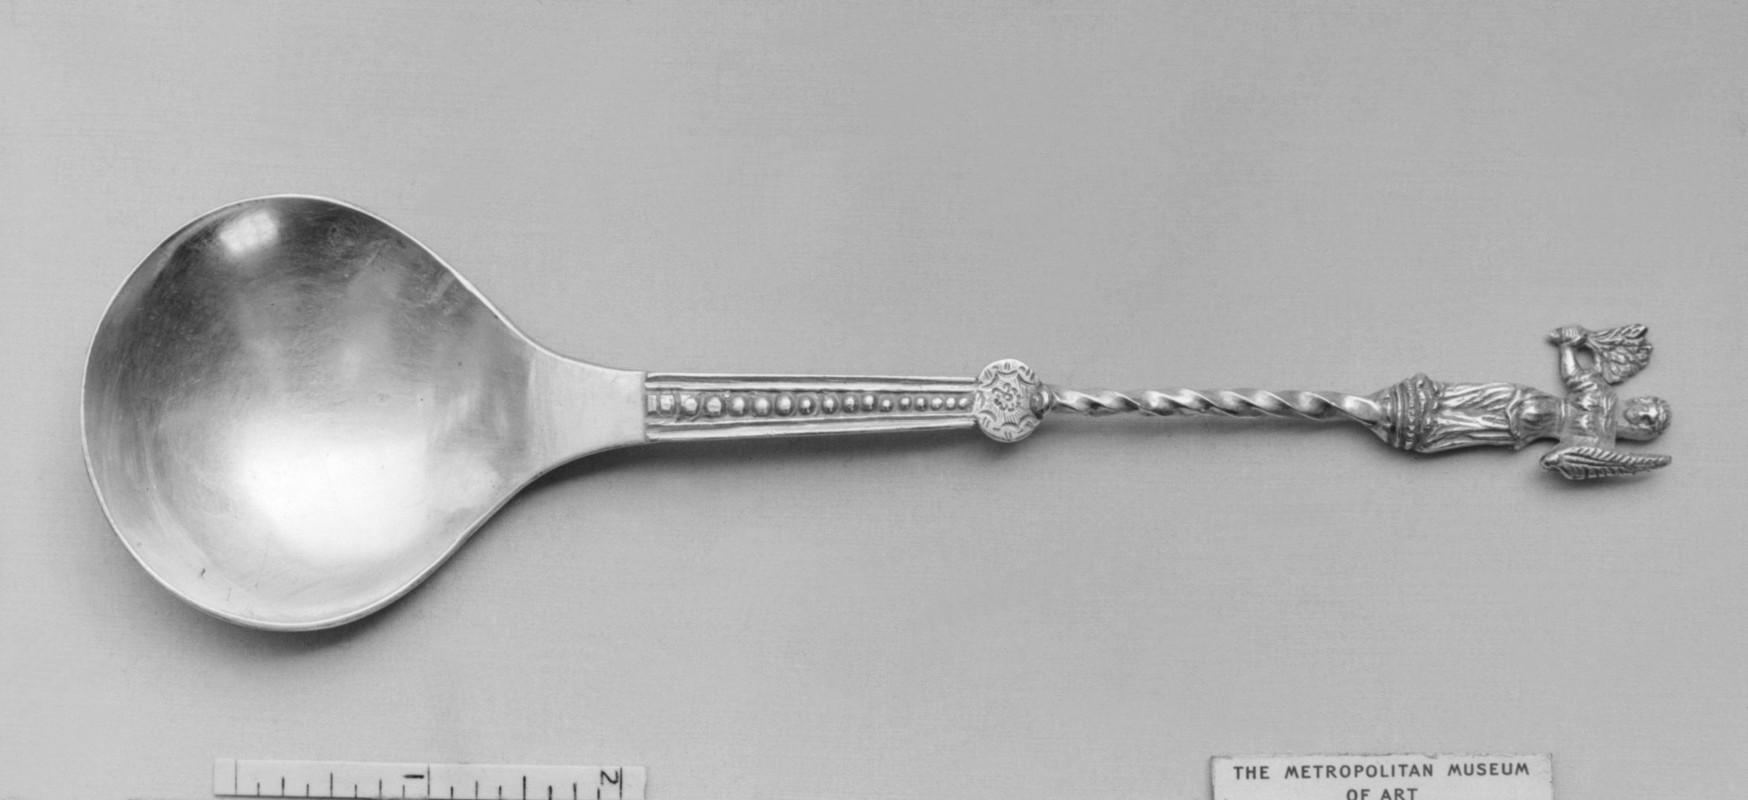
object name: spoon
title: Figure-top spoon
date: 1801-1900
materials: silver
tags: women